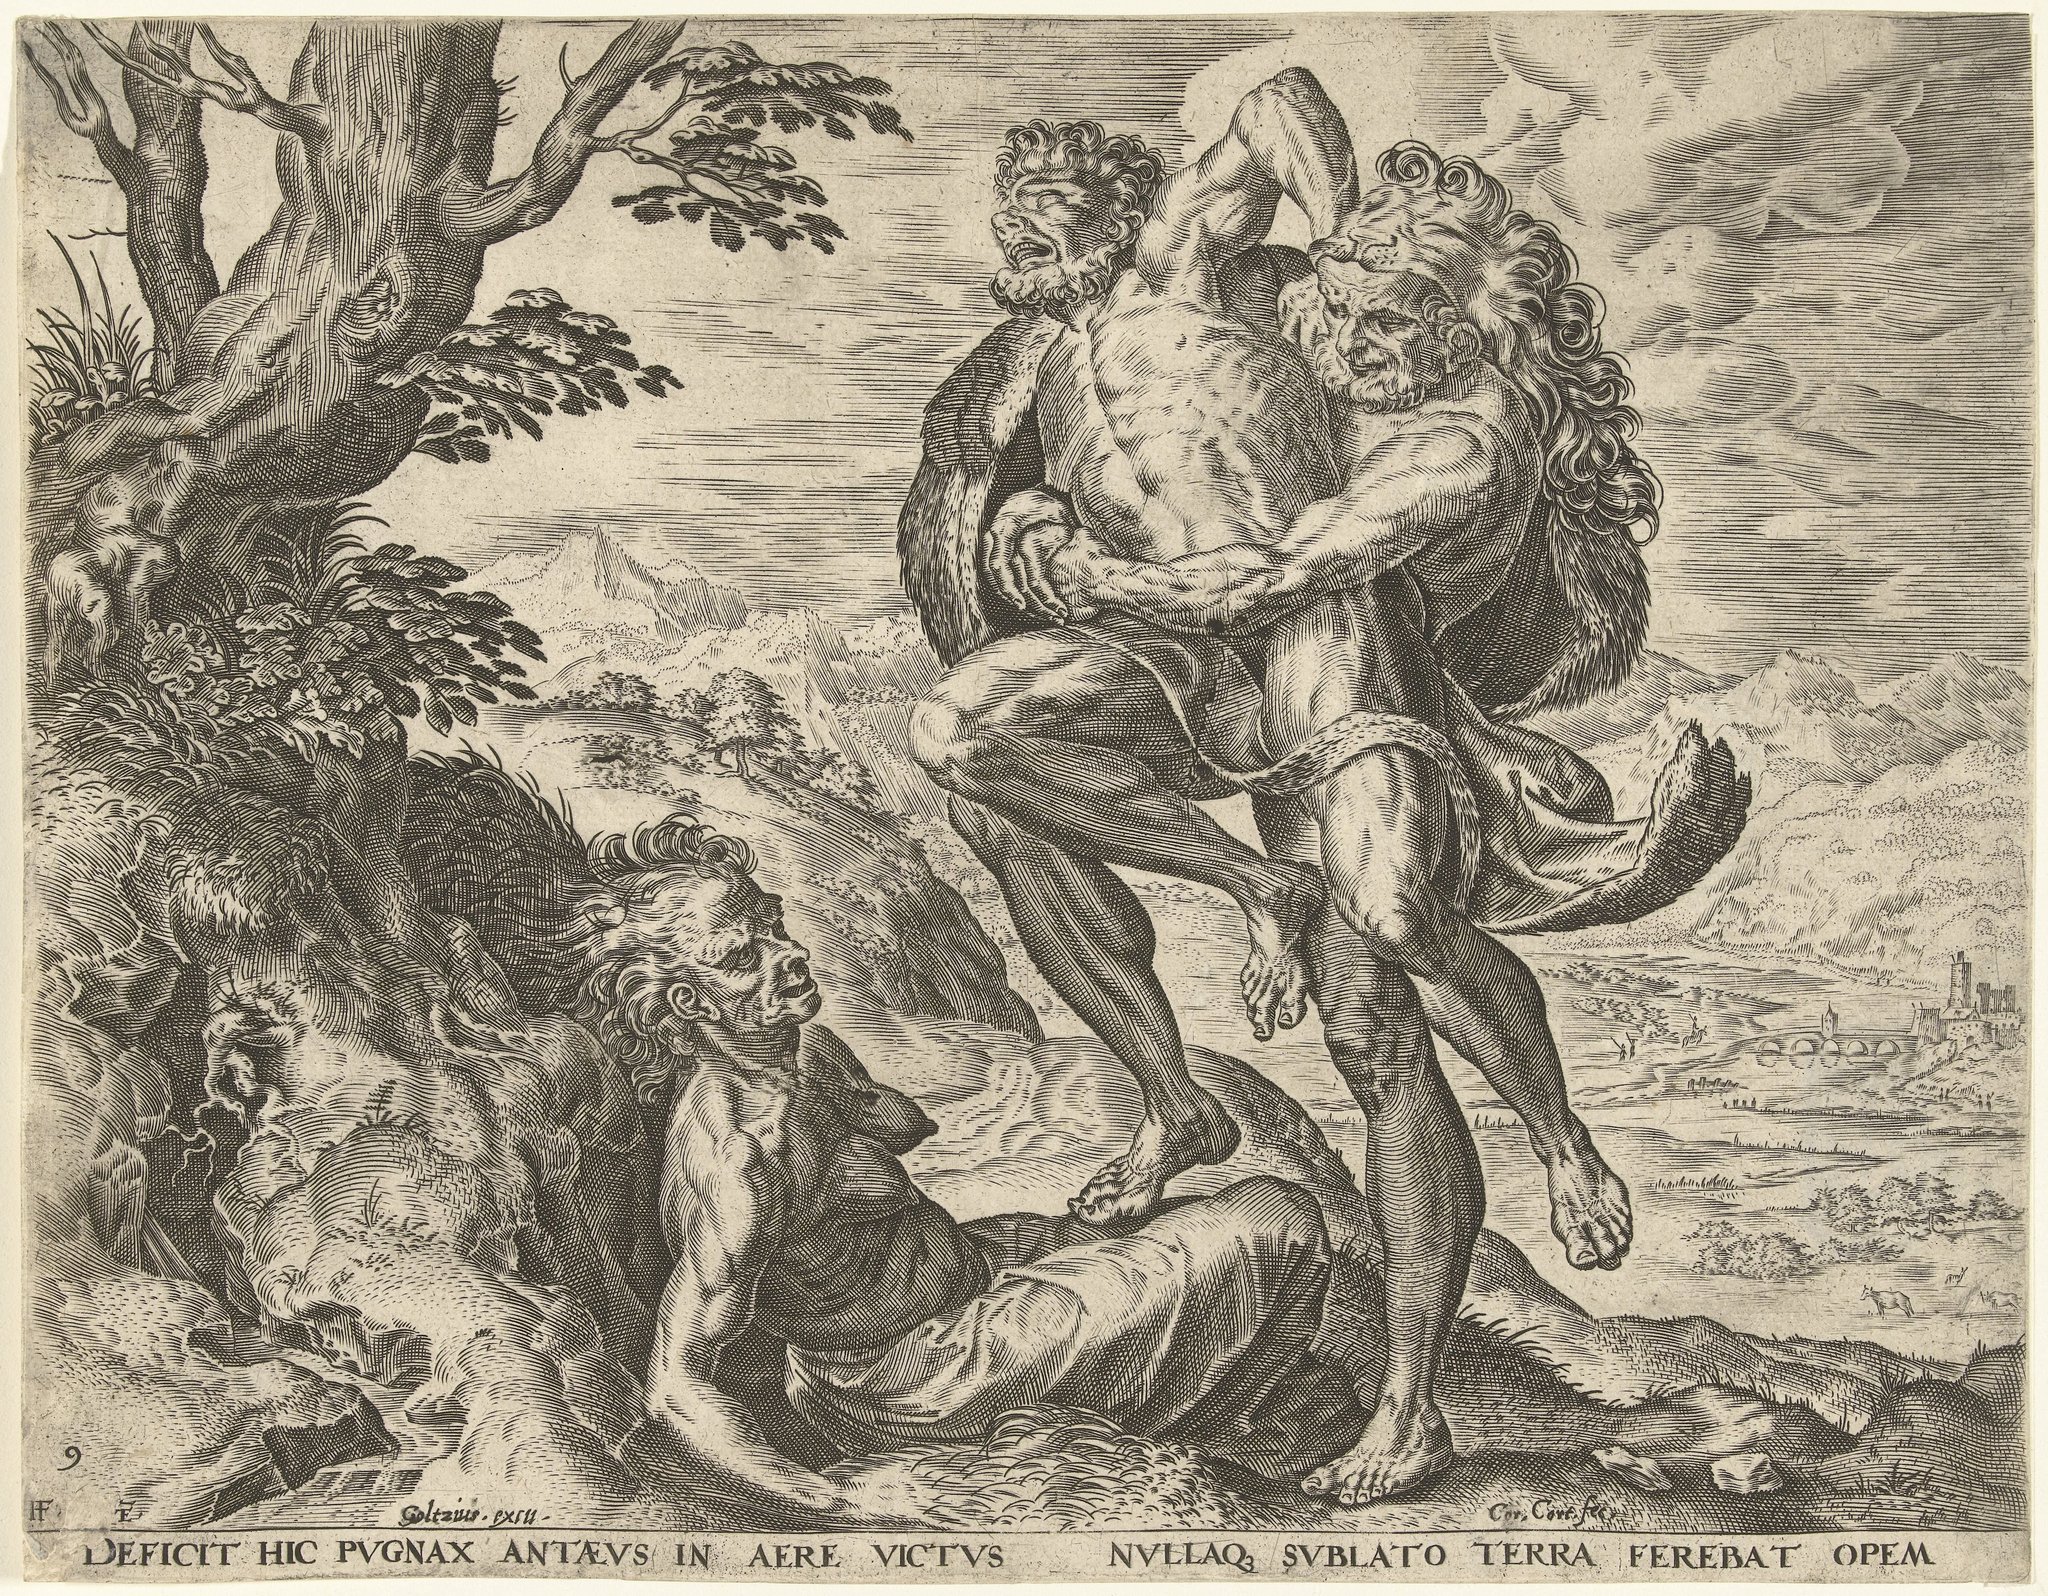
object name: print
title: Hercules worstelt met Antaeus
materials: paper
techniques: engraving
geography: antwerp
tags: the giant antaeus is lifted in the air and crushed to death by hercules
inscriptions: collector's mark: Lugt 10, collector's mark: Lugt 11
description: Hercules verslaat de reus Antaeus door hem zolang op te tillen totdat hij zijn weerstand opgeeft en sterft.